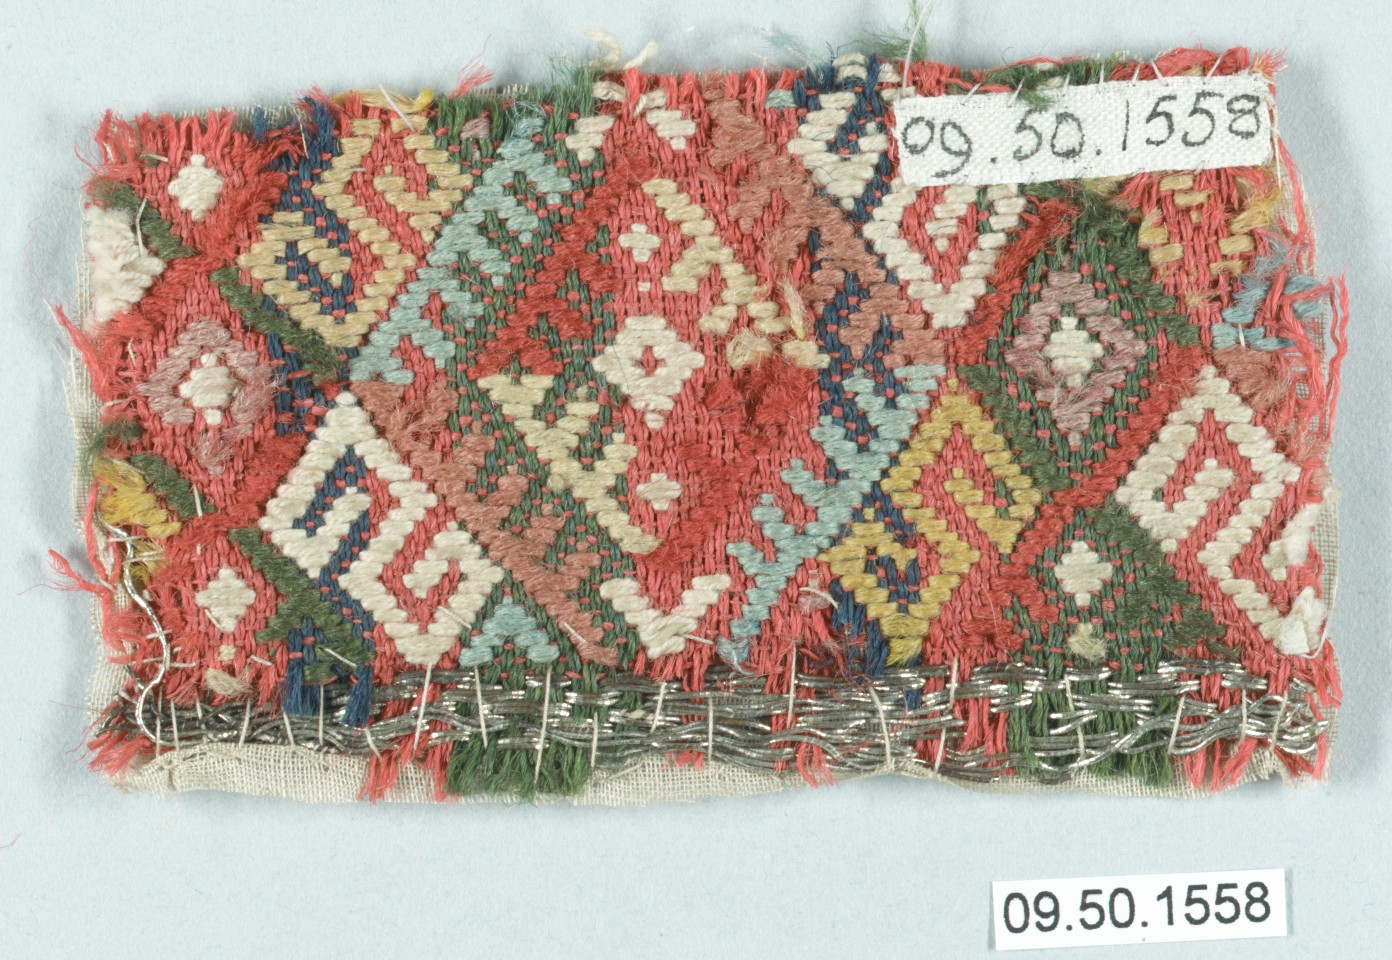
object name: fragment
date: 1801-1833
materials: metal thread